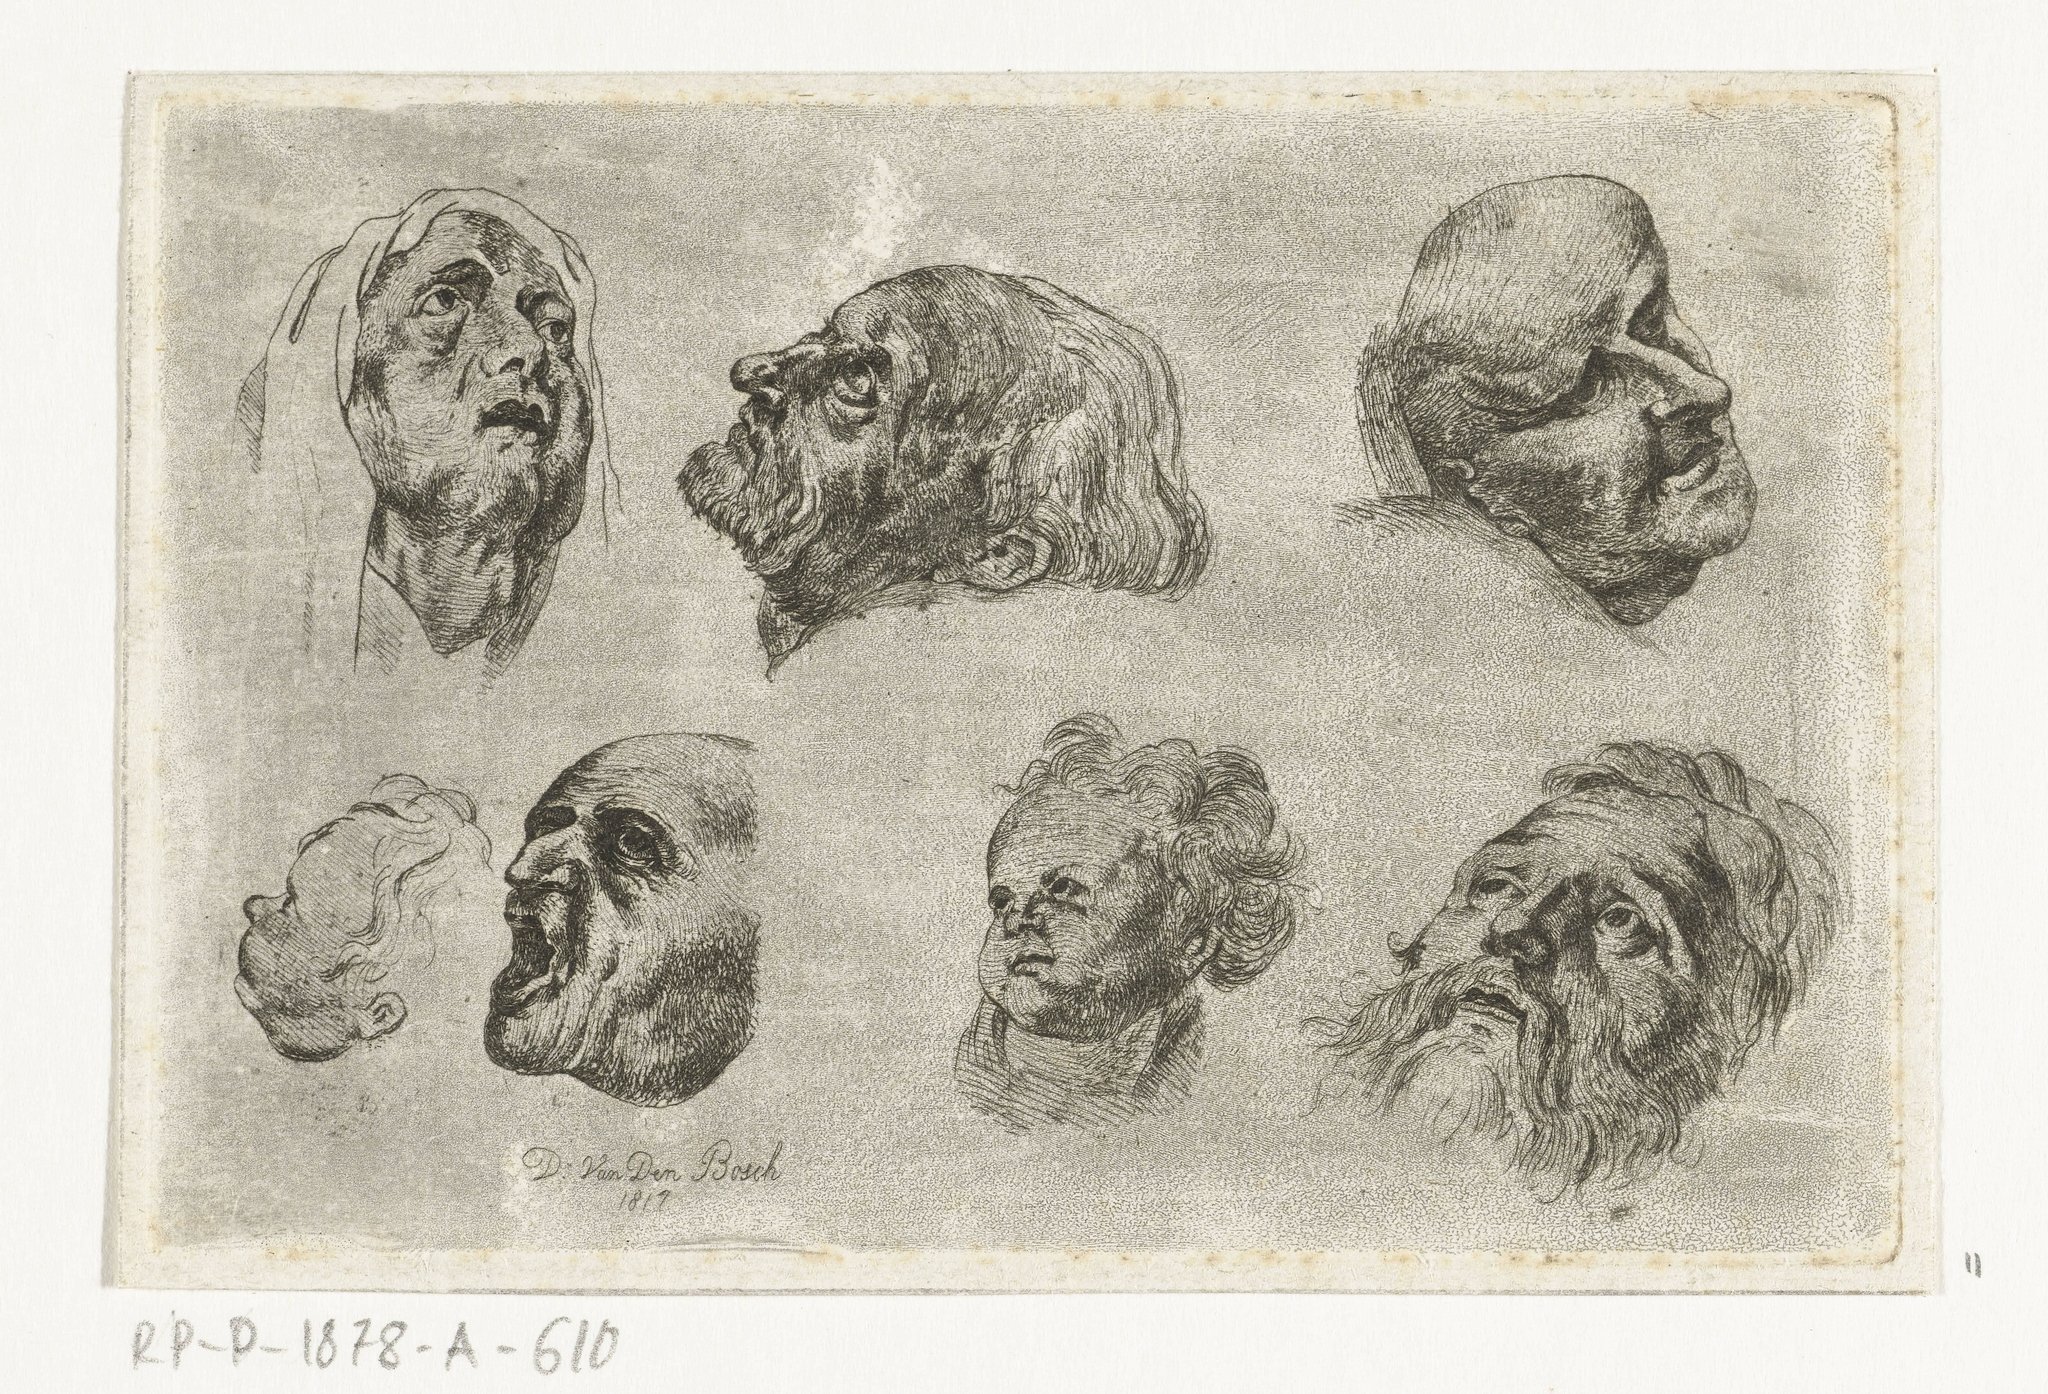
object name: print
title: Studieblad met zeven hoofden in twee rijen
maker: d. van den bosch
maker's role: print maker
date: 1817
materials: paper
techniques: aquatint, etching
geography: netherlands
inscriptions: collector's mark: Lugt 2227